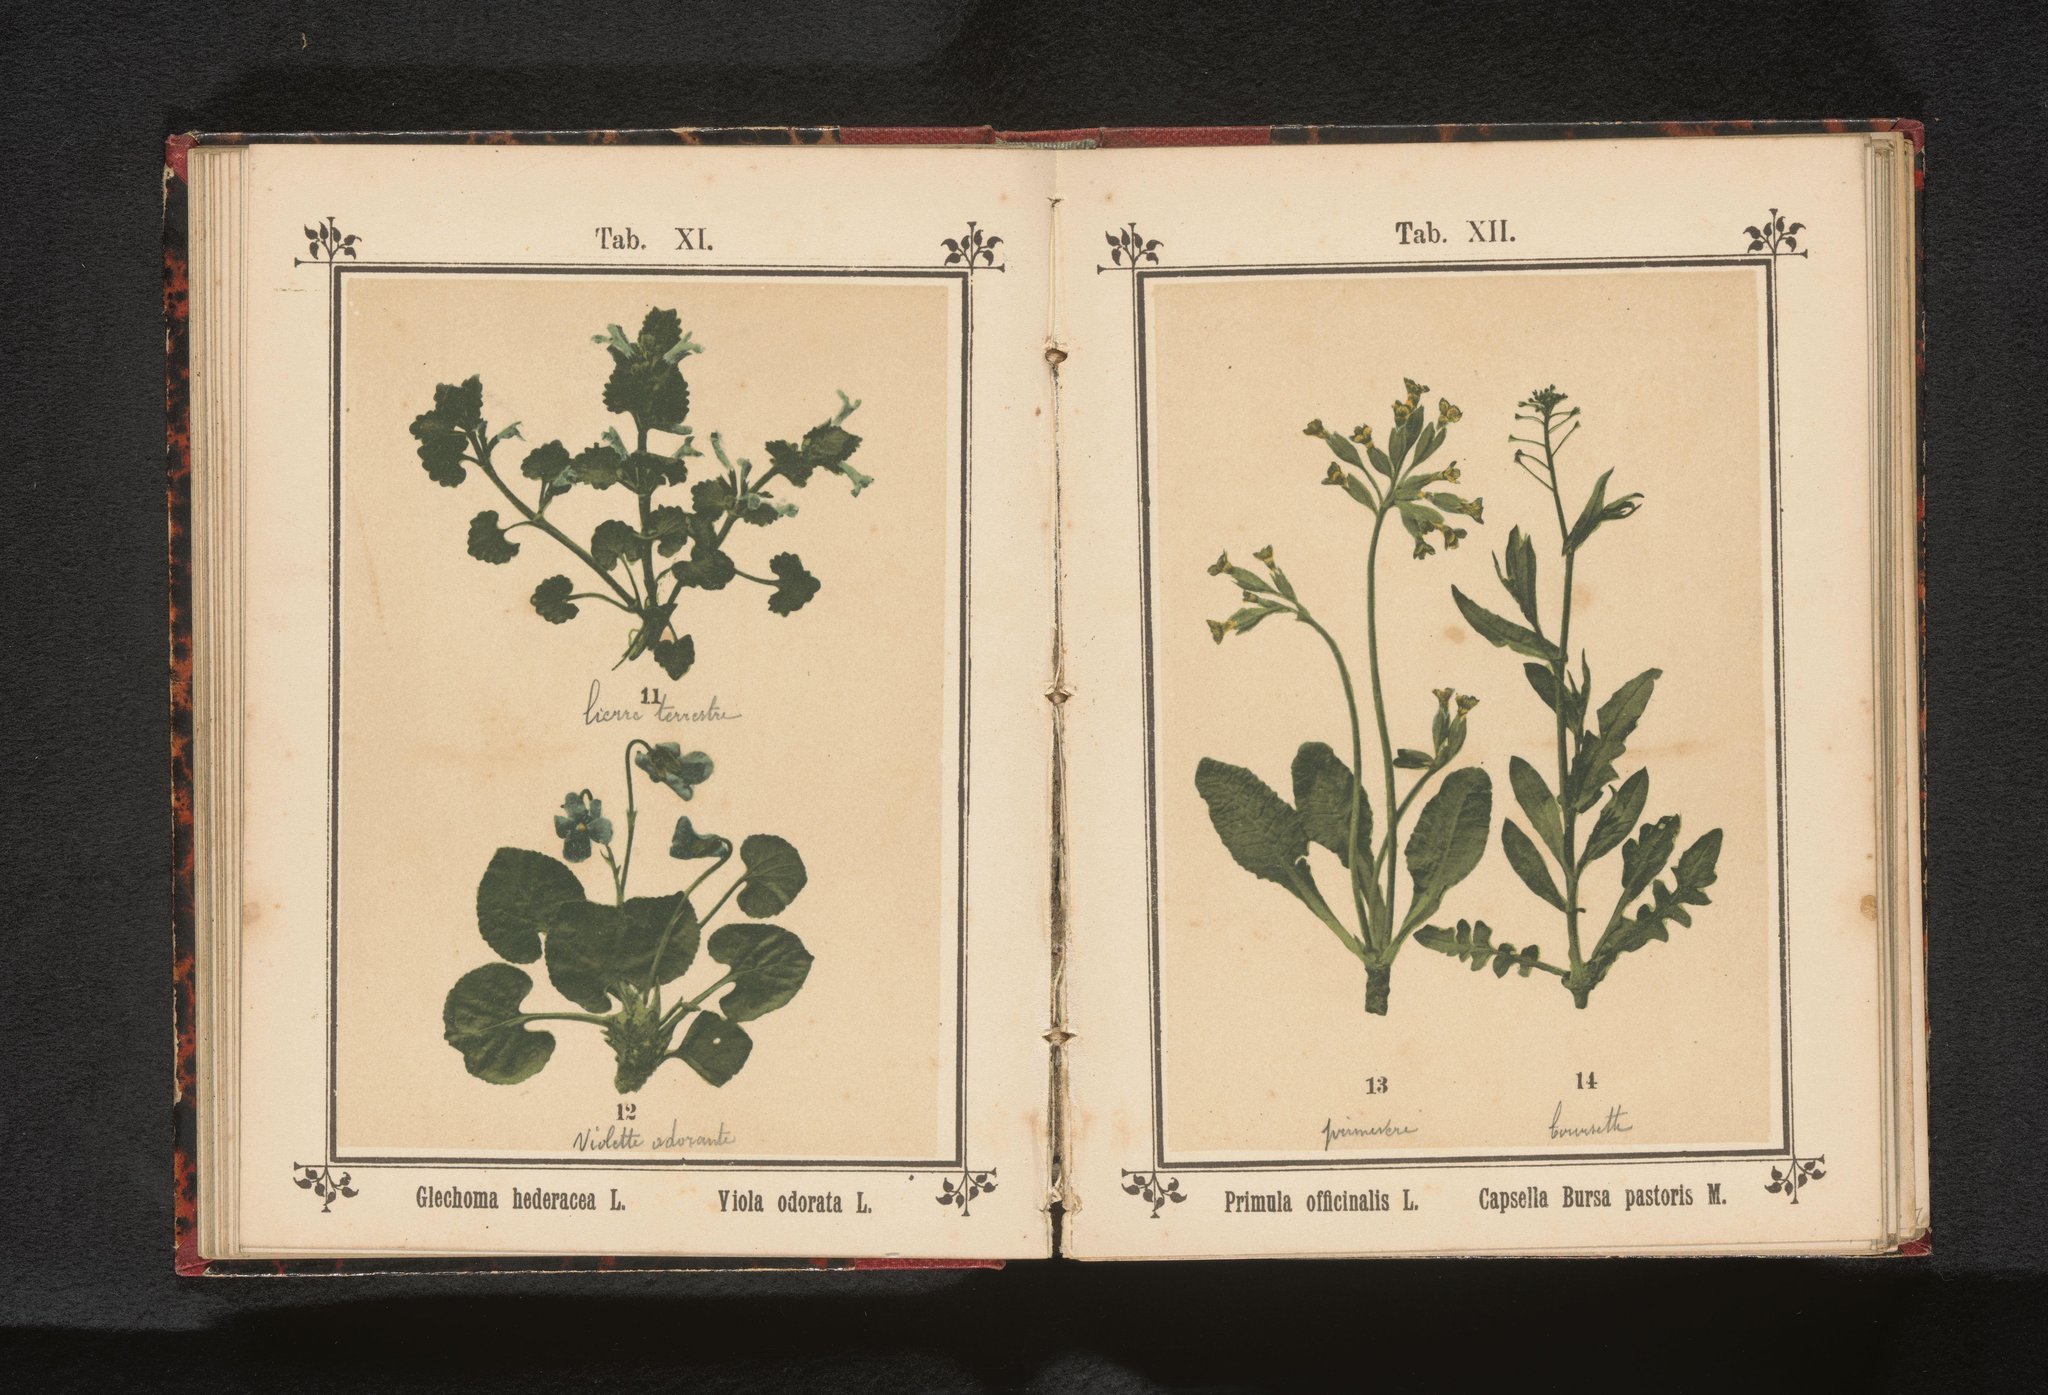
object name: page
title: Glechoma hederacea L. Viola odorata L.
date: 1884-1894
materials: paper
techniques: photograph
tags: flowers, plants and herbs: ivy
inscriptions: inscription: ‘lierre terrestre violette odorante’, number: ‘Tab. XI.’